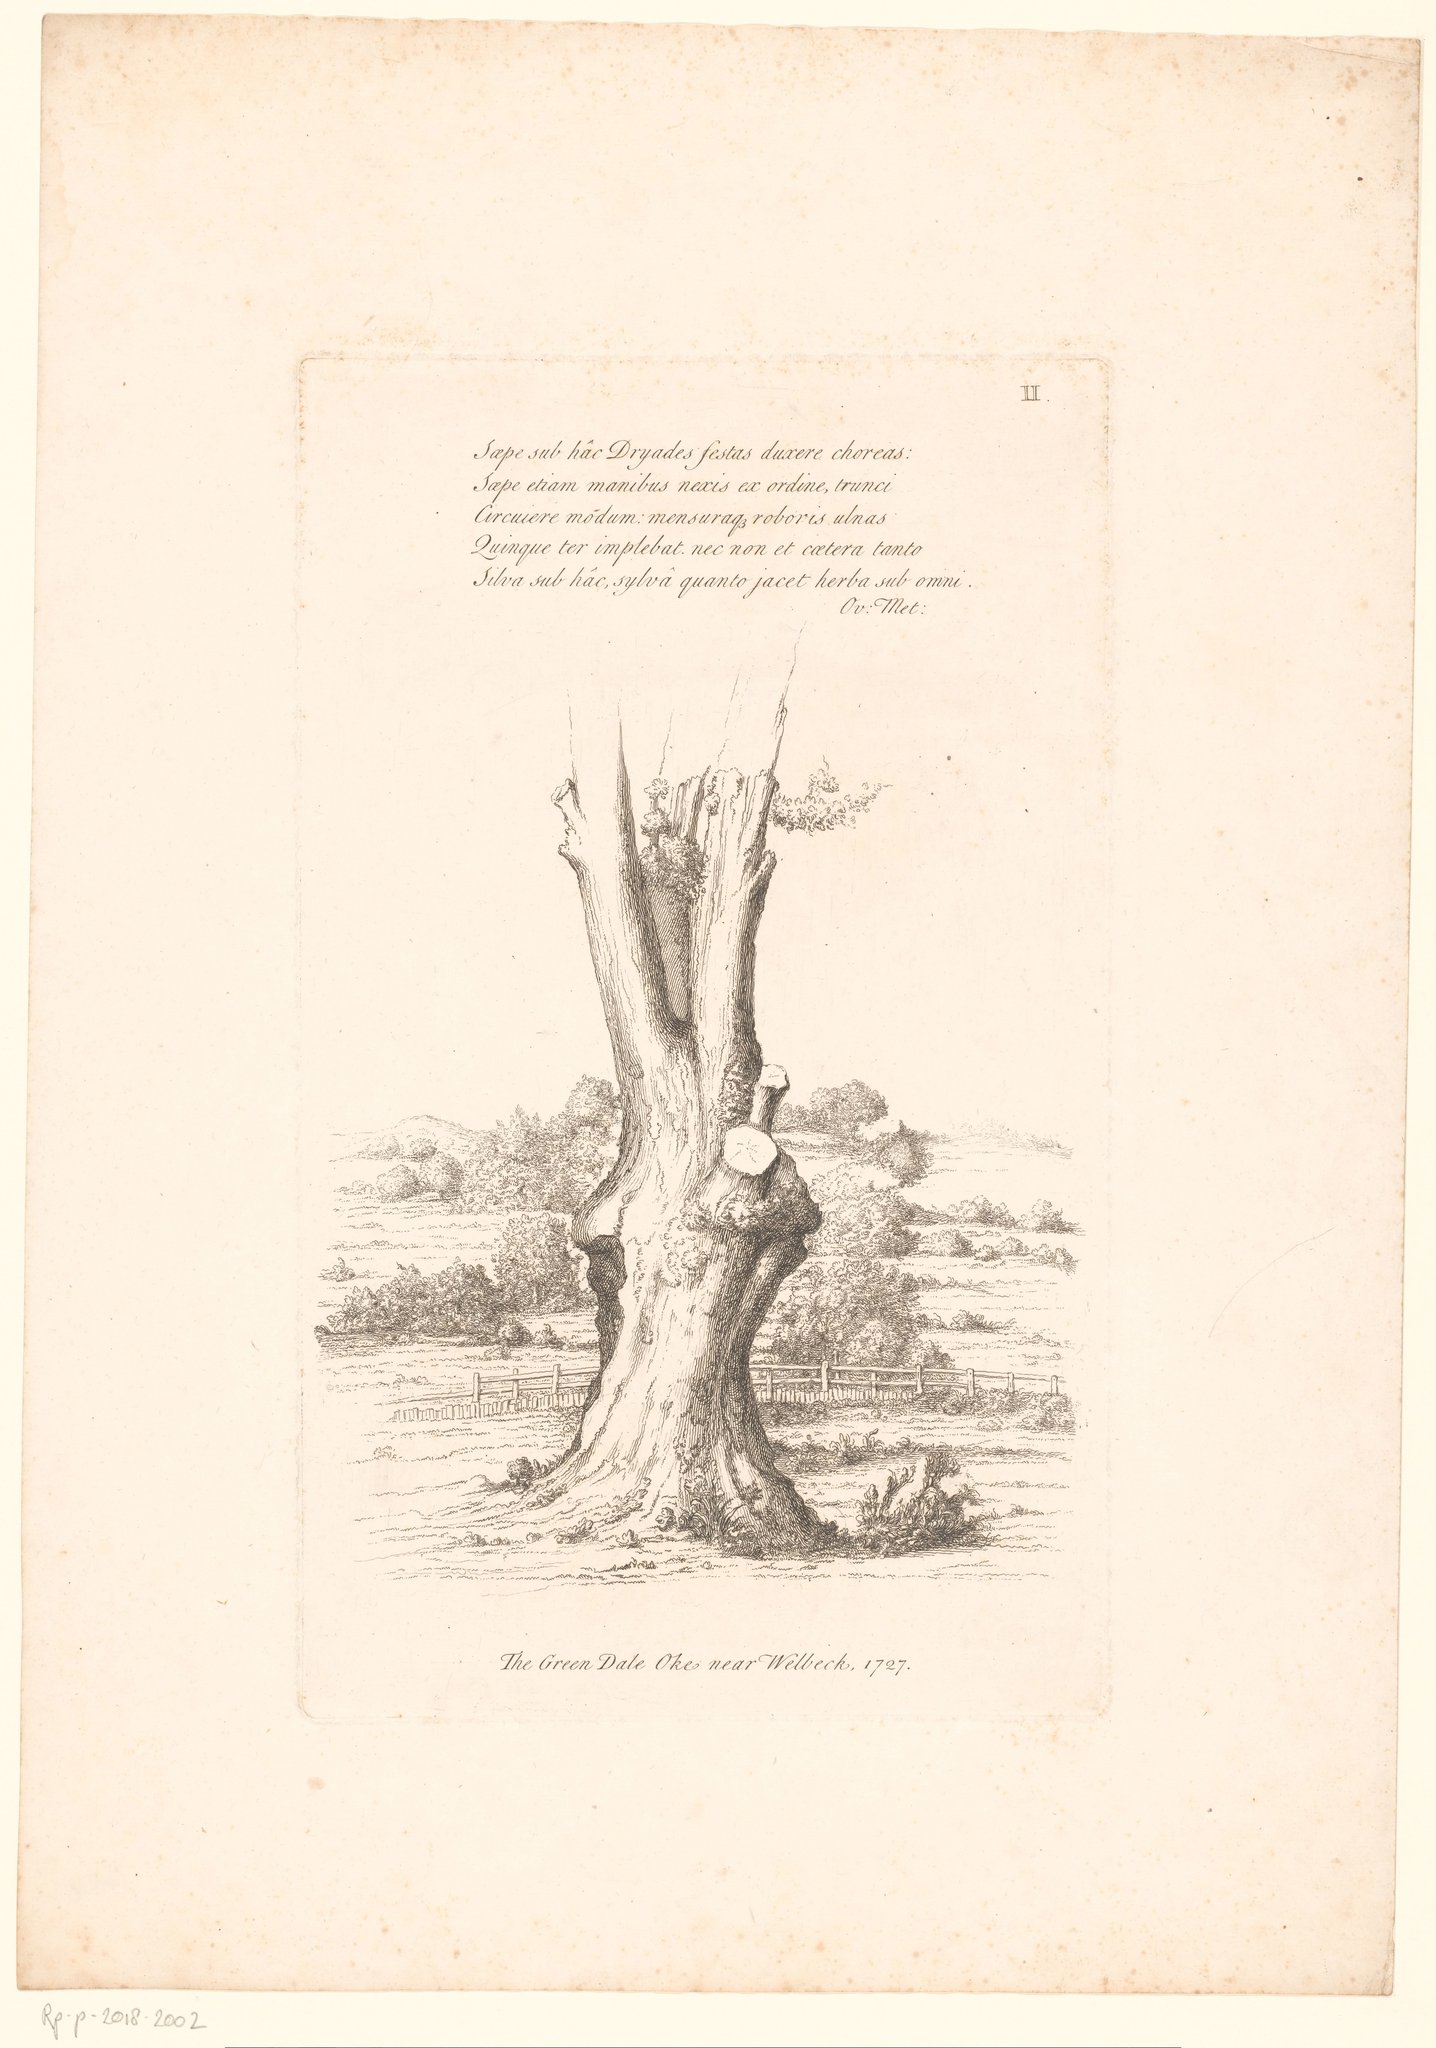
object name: print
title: The Green Dale Oke near Welbeck, 1727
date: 1727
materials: paper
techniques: etching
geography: london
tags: trees: oak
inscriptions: collector's mark: Lugt 2228